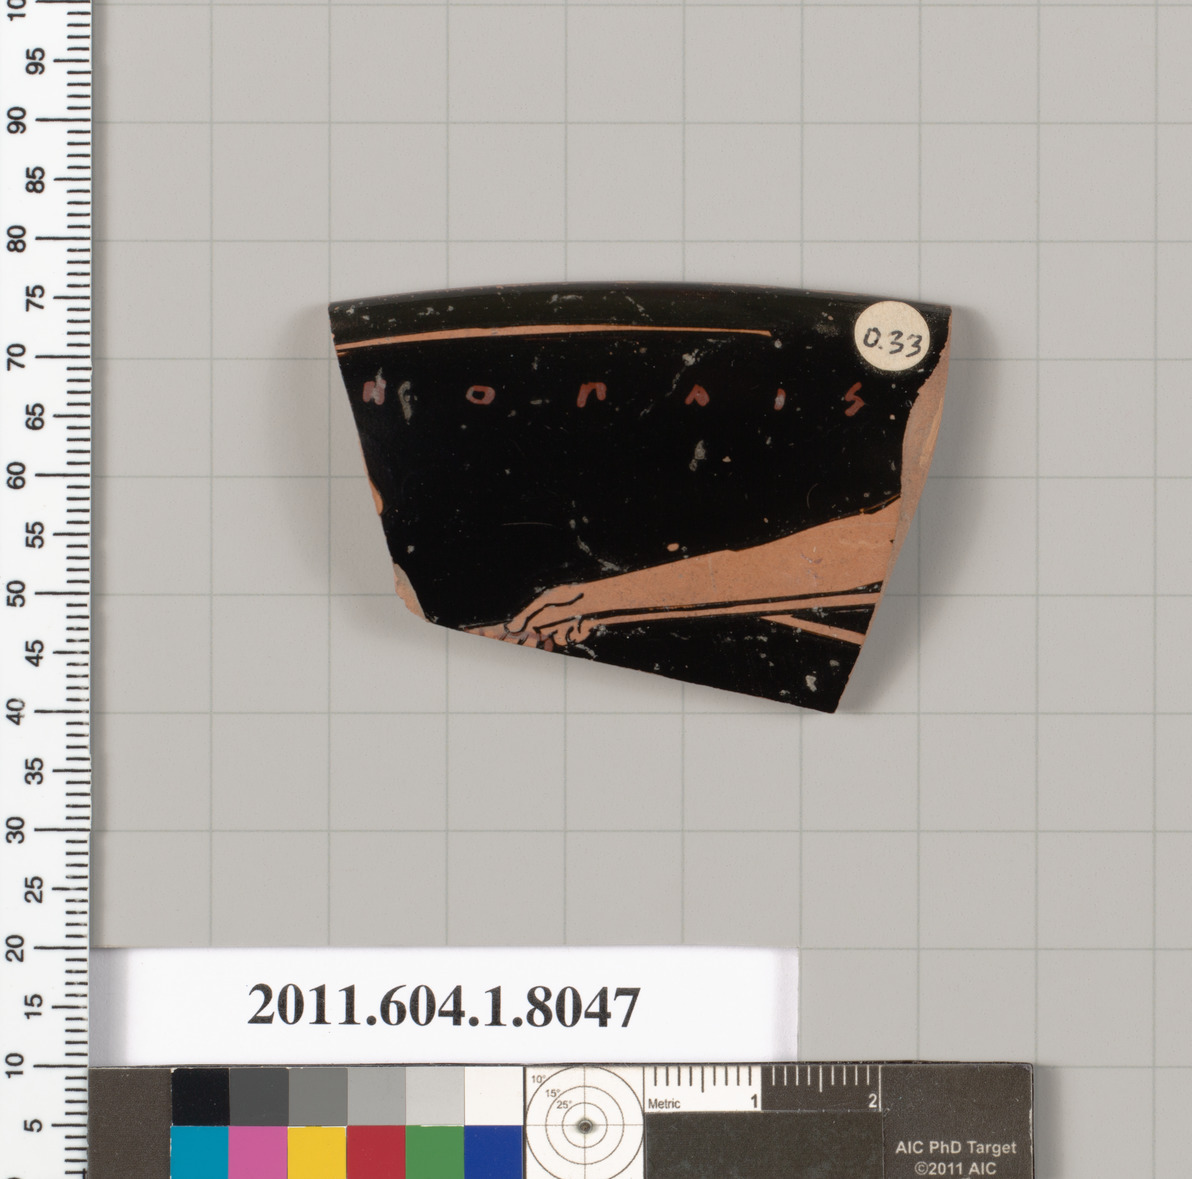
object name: kylix fragment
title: Terracotta rim fragment of a kylix (drinking cup)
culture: greek, attic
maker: triptolemos painter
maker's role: artist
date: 510-500 BCE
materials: terracotta